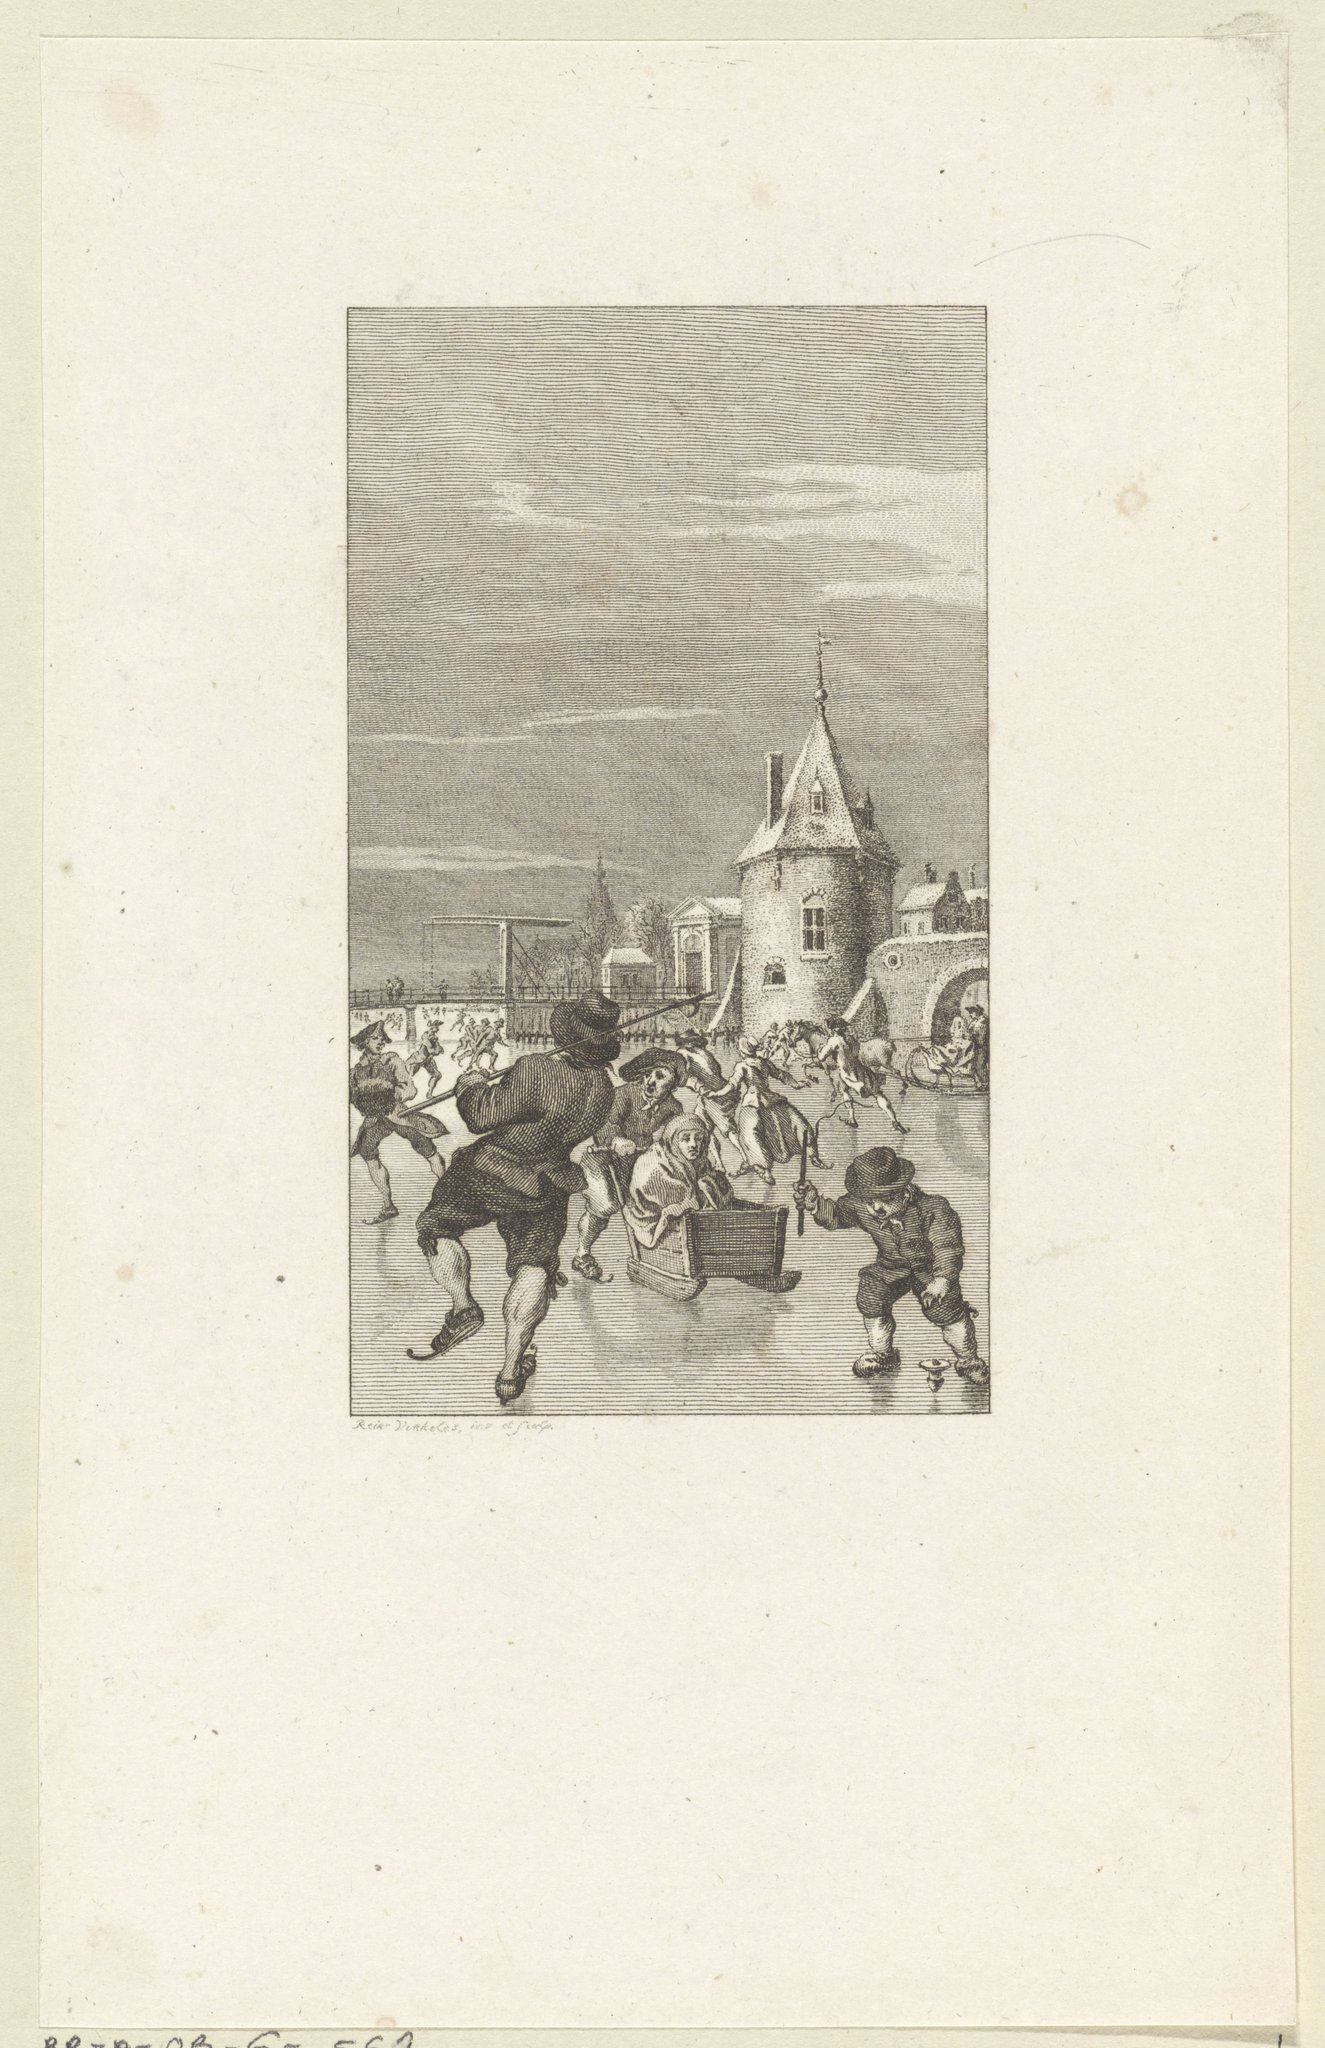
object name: print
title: IJspret buiten de stadsmuren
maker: reinier vinkeles (i)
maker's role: draughtsman, print maker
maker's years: 1741-1816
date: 1751-1816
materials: paper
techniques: engraving, etching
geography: amsterdam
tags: sleigh, sledge (non-sport), skates (winter sports), city-walls, ice ~ state of water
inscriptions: collector's mark: Lugt 240